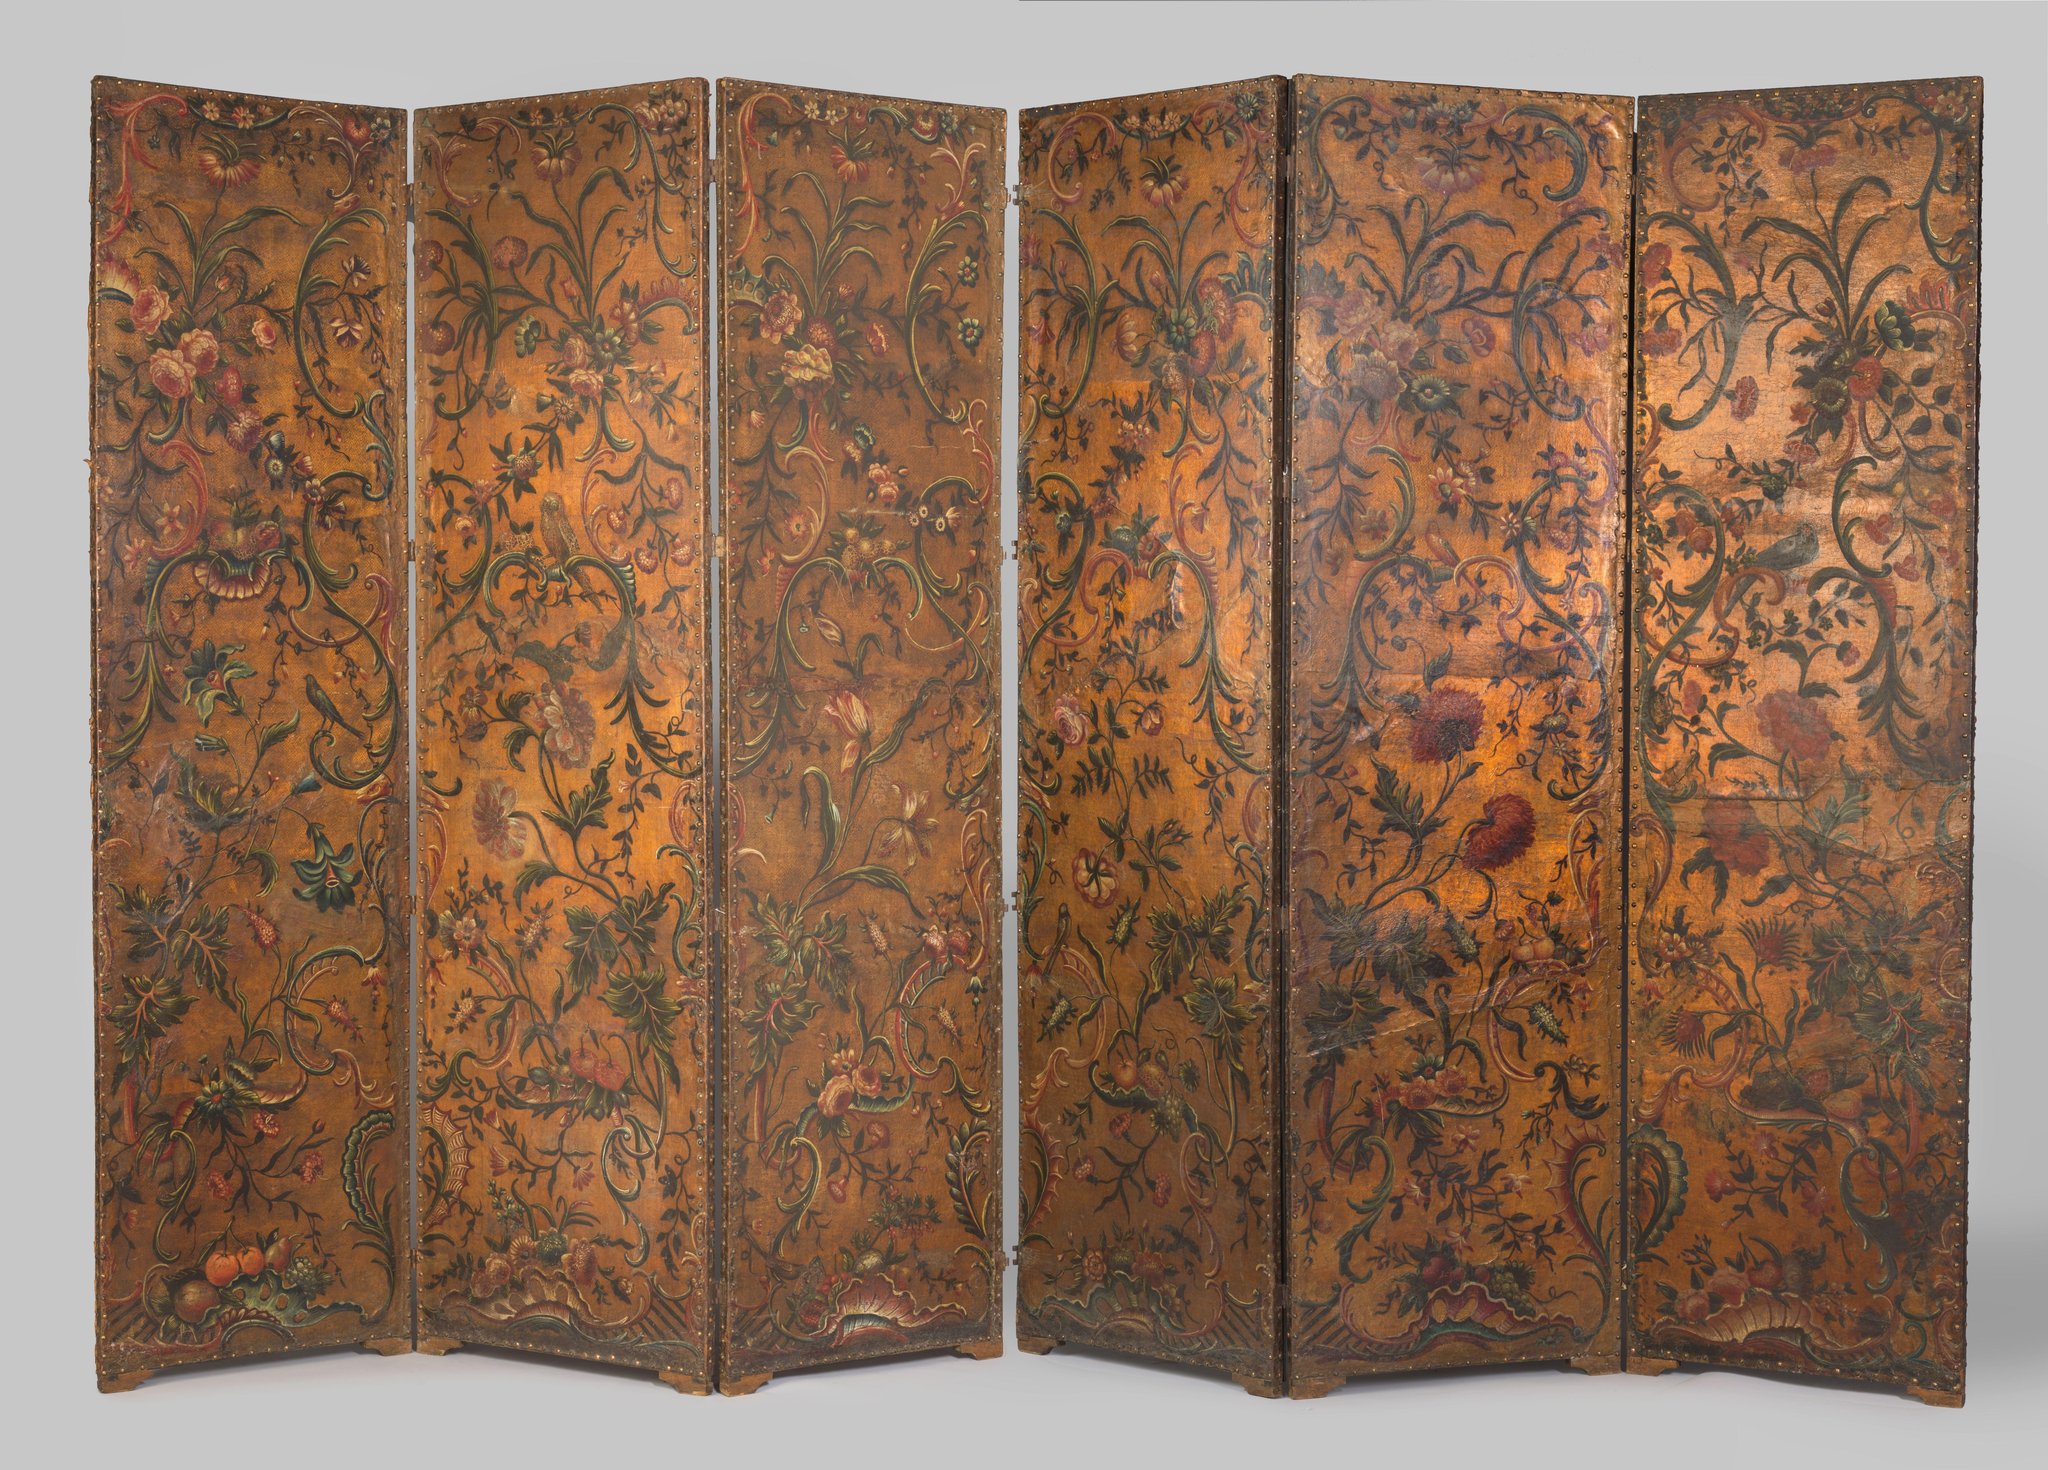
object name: screen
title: Kamerscherm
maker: Anonymous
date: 1750-1800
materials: gilt leather, wood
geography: northern netherlands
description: Kamerscherm van zes slagen, bespannen met goudleer. Het scherm vertoont op geperste gouden fond rocailles, bloem- en bladranken, vruchten en gekleurde vogels.